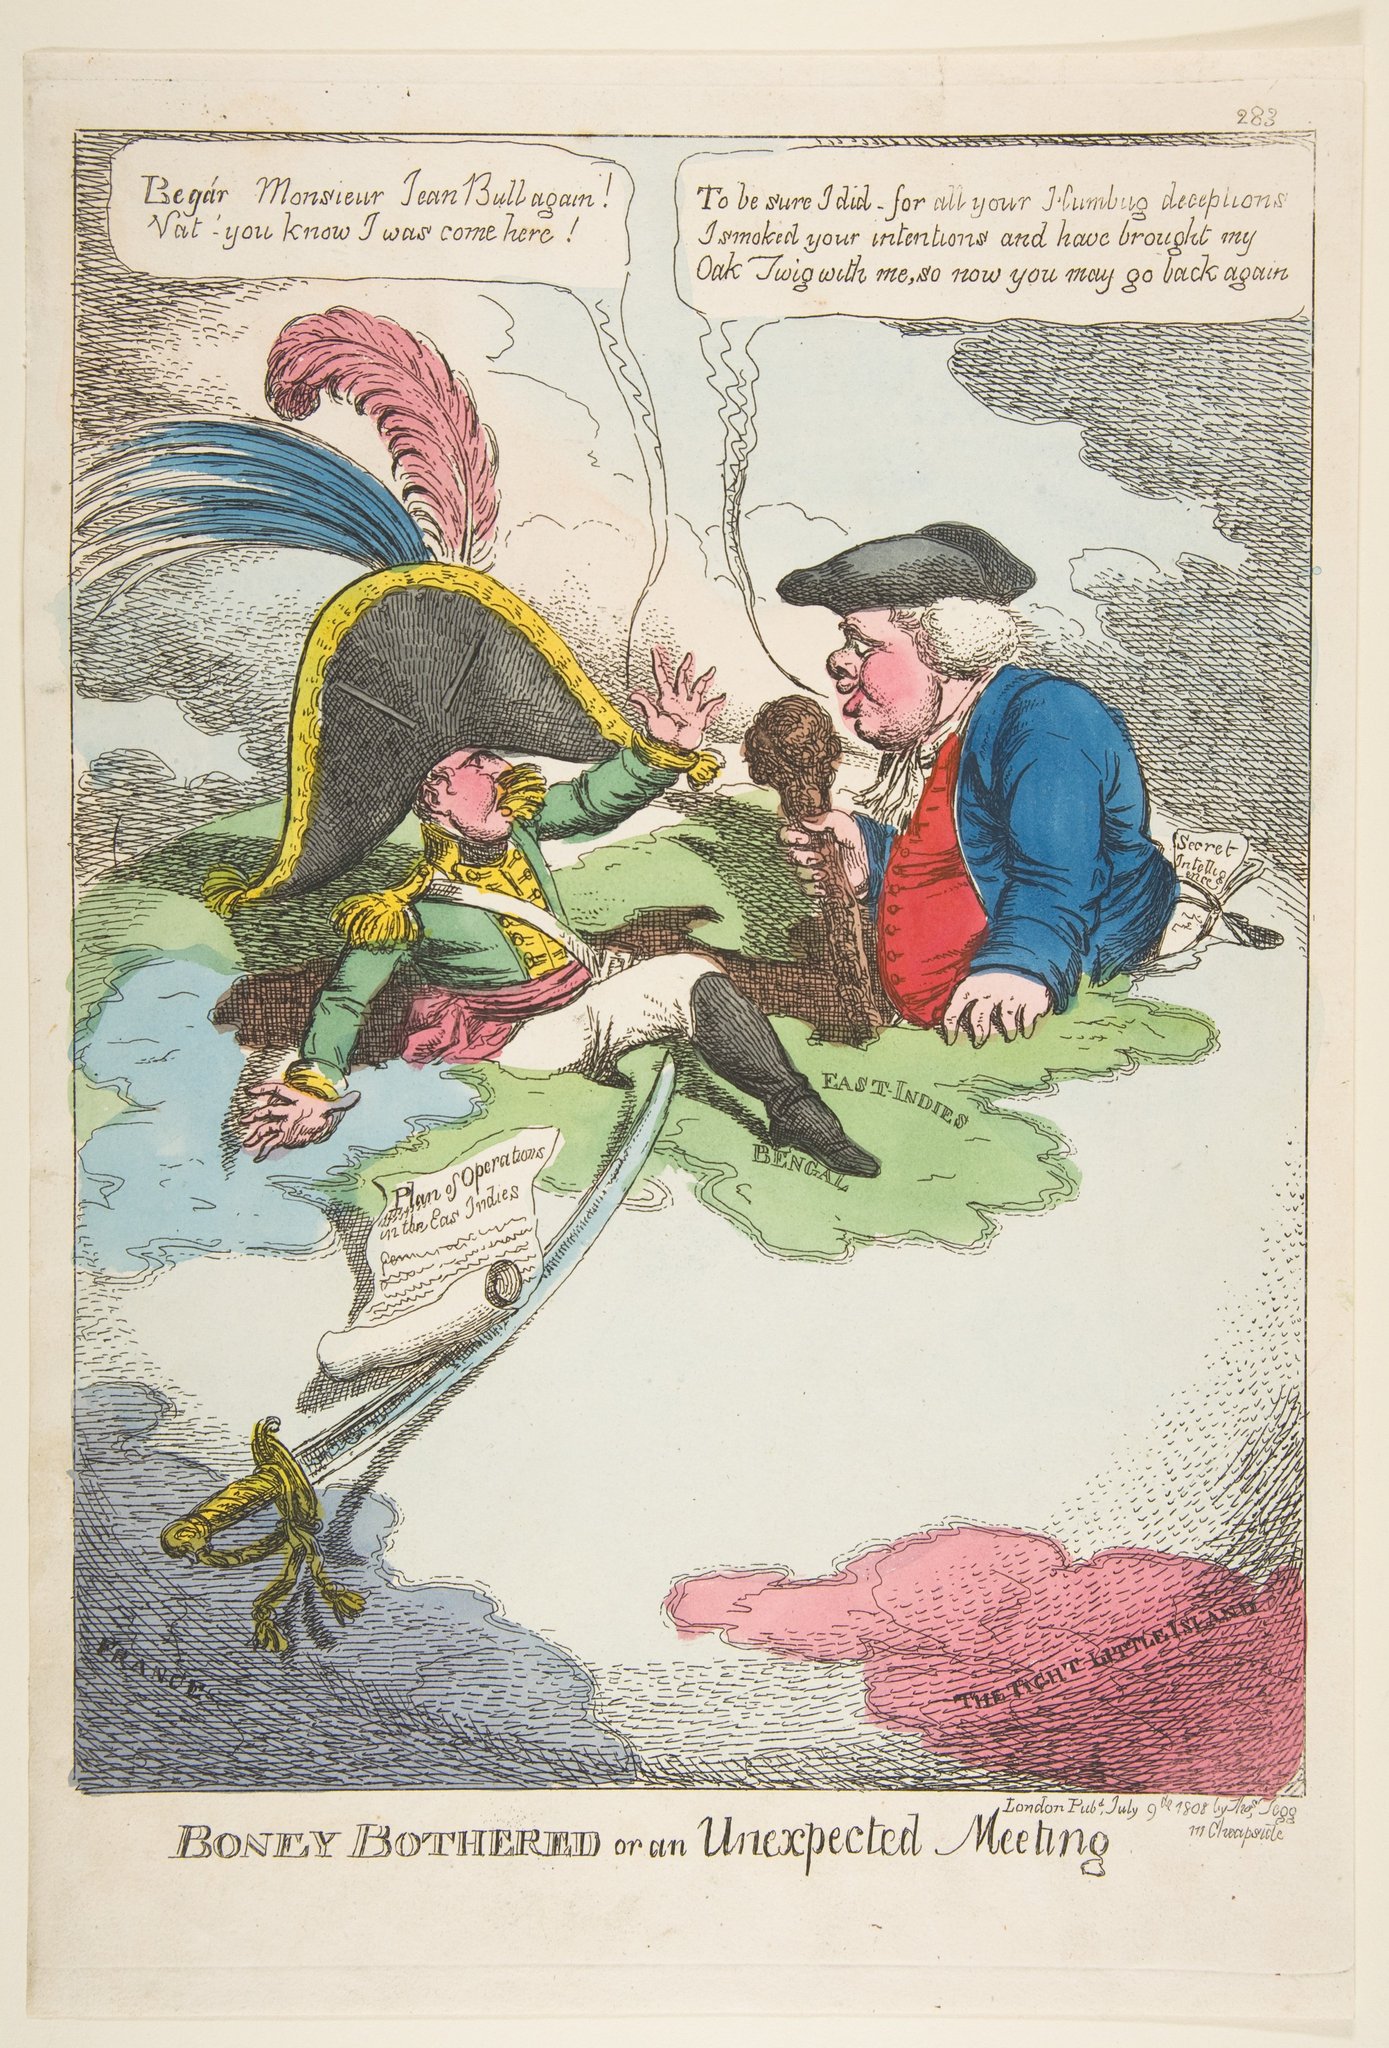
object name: print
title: Boney Bothered or an Unexpected Meeting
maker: charles williams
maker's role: artist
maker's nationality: british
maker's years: 1750-1850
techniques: etching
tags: satire,napoleon i,men,politics